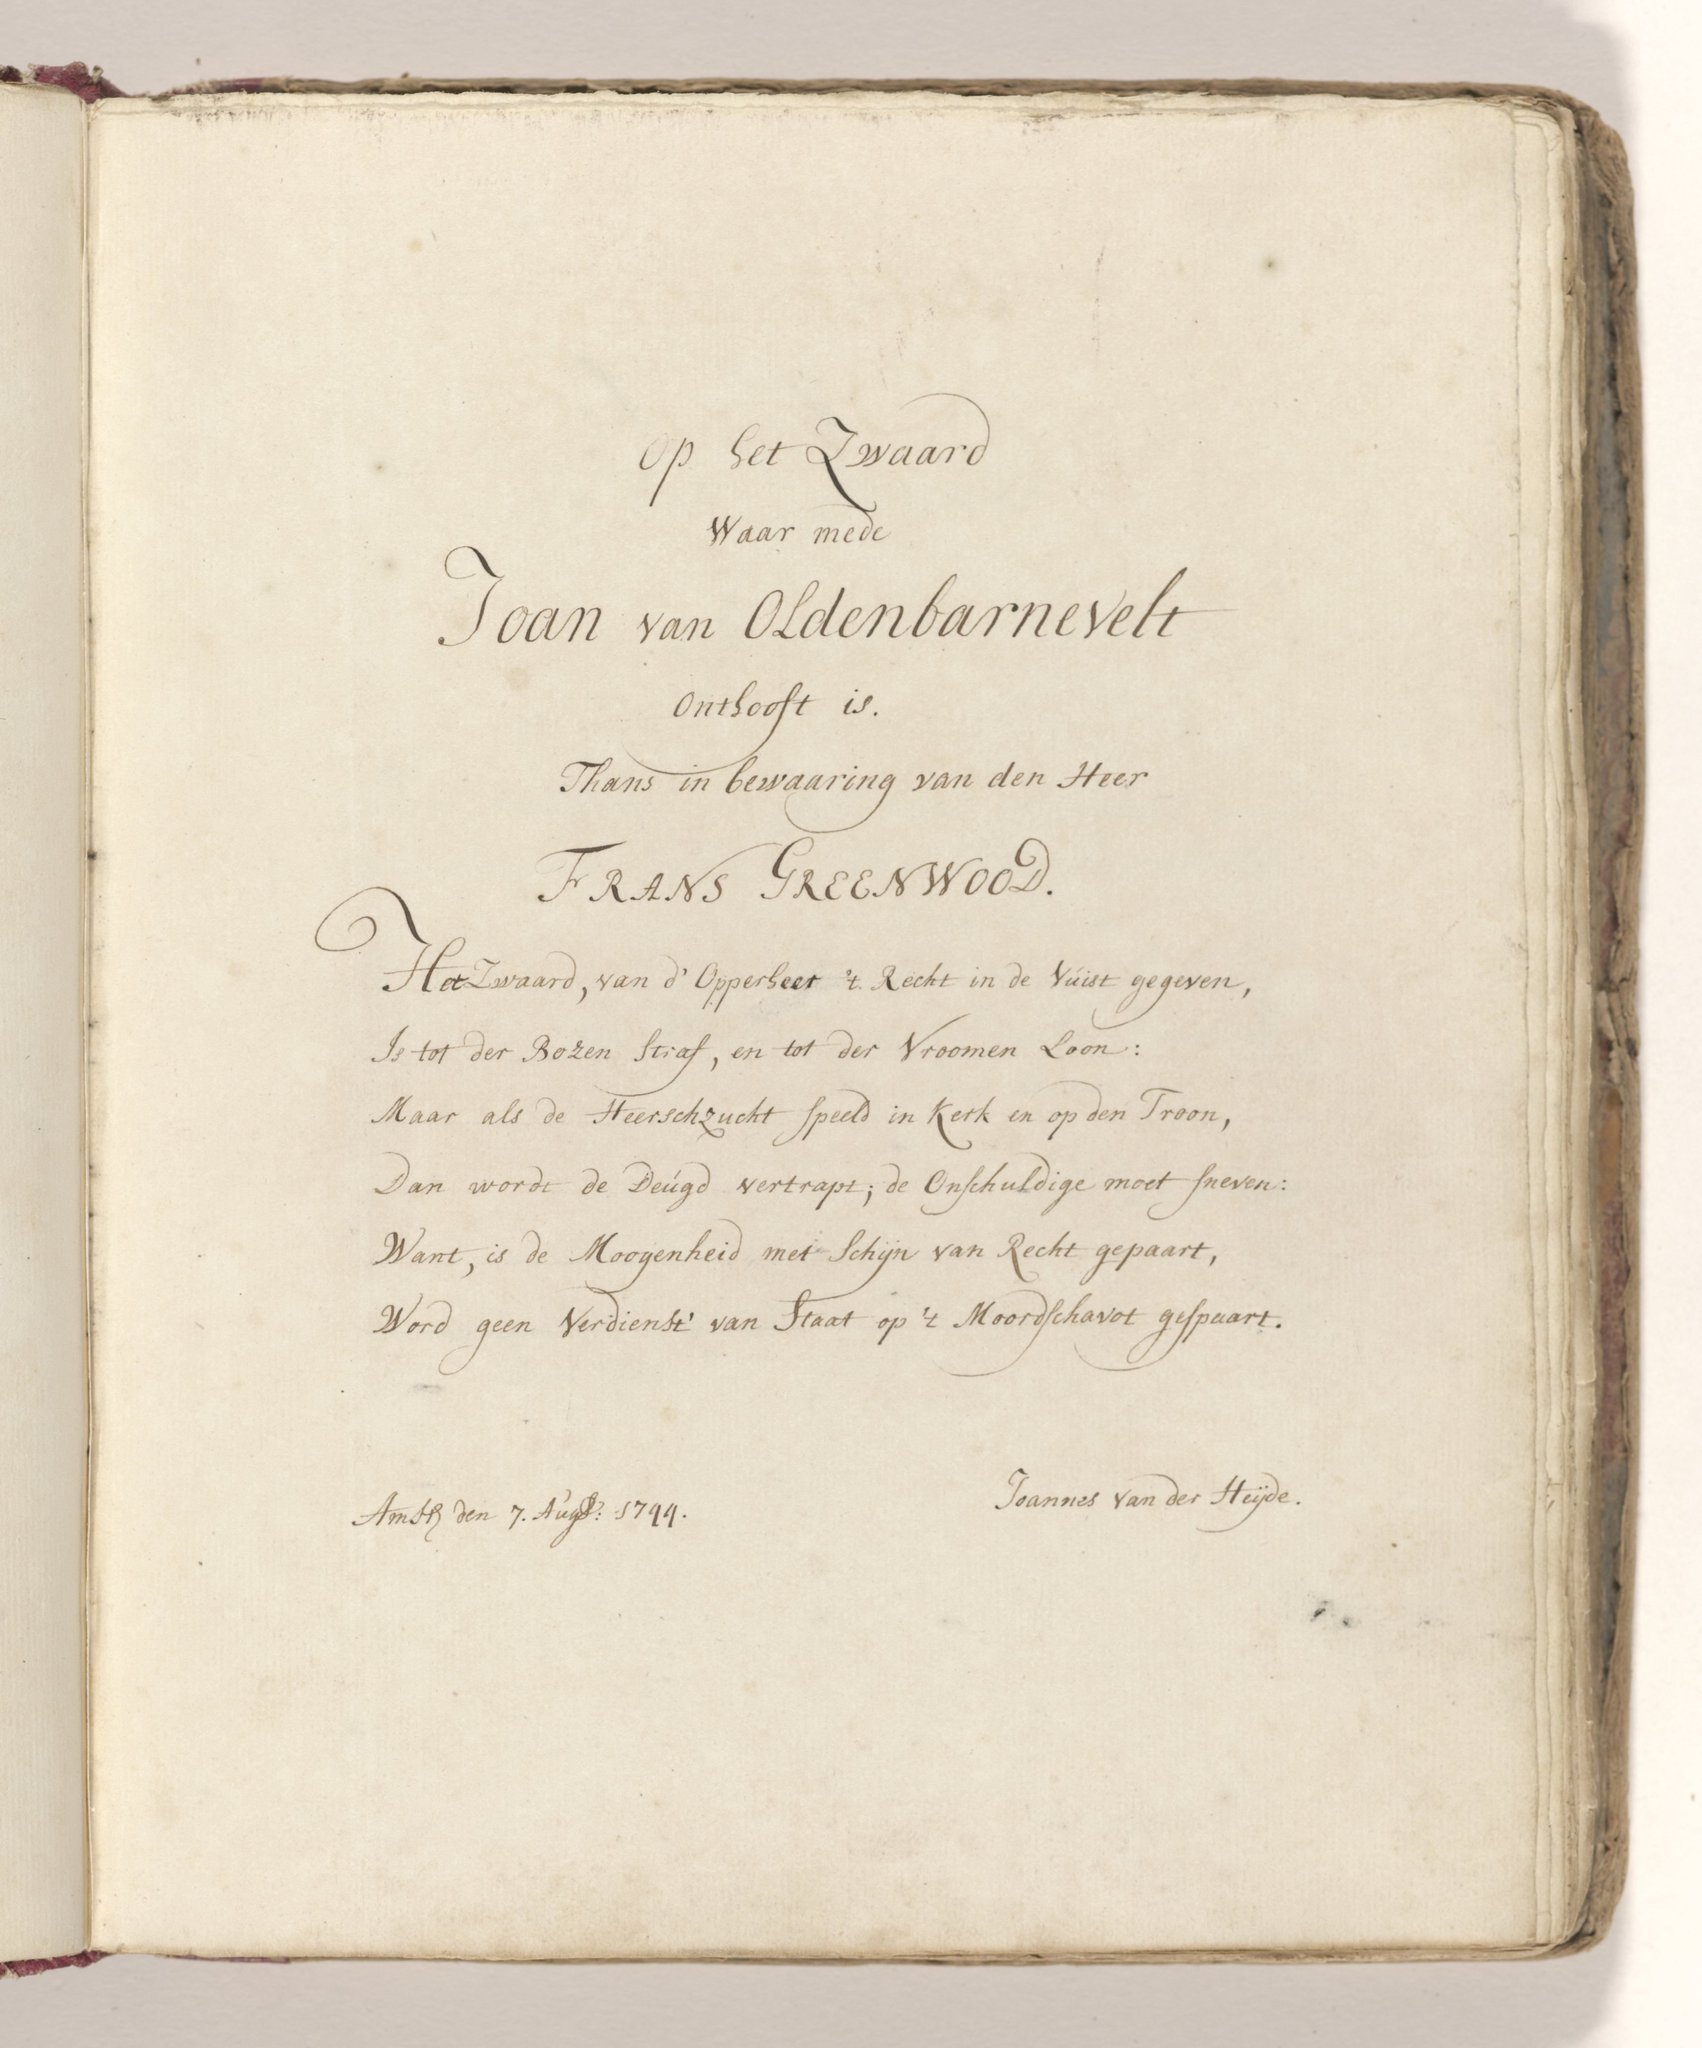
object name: manuscript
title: Gedicht op het zwaard waarmee Johan van Oldenbarnevelt in 1619 zou zijn onthoofd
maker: johannes van der heyde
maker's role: dichter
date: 1744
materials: ink, paper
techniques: writing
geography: amsterdam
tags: johan van oldenbarnevelt, rotterdam, dordrecht, print maker, frans greenwood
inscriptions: date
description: Vers van Johannes van der Heyde (Heijde). Onderdeel van het boek met gedichten uit de jaren 1743-1745 op het zwaard waarmee Johan van Oldenbarnevelt in 1619 zou zijn onthoofd. Het zwaard was eigendom van Frans Greenwood.